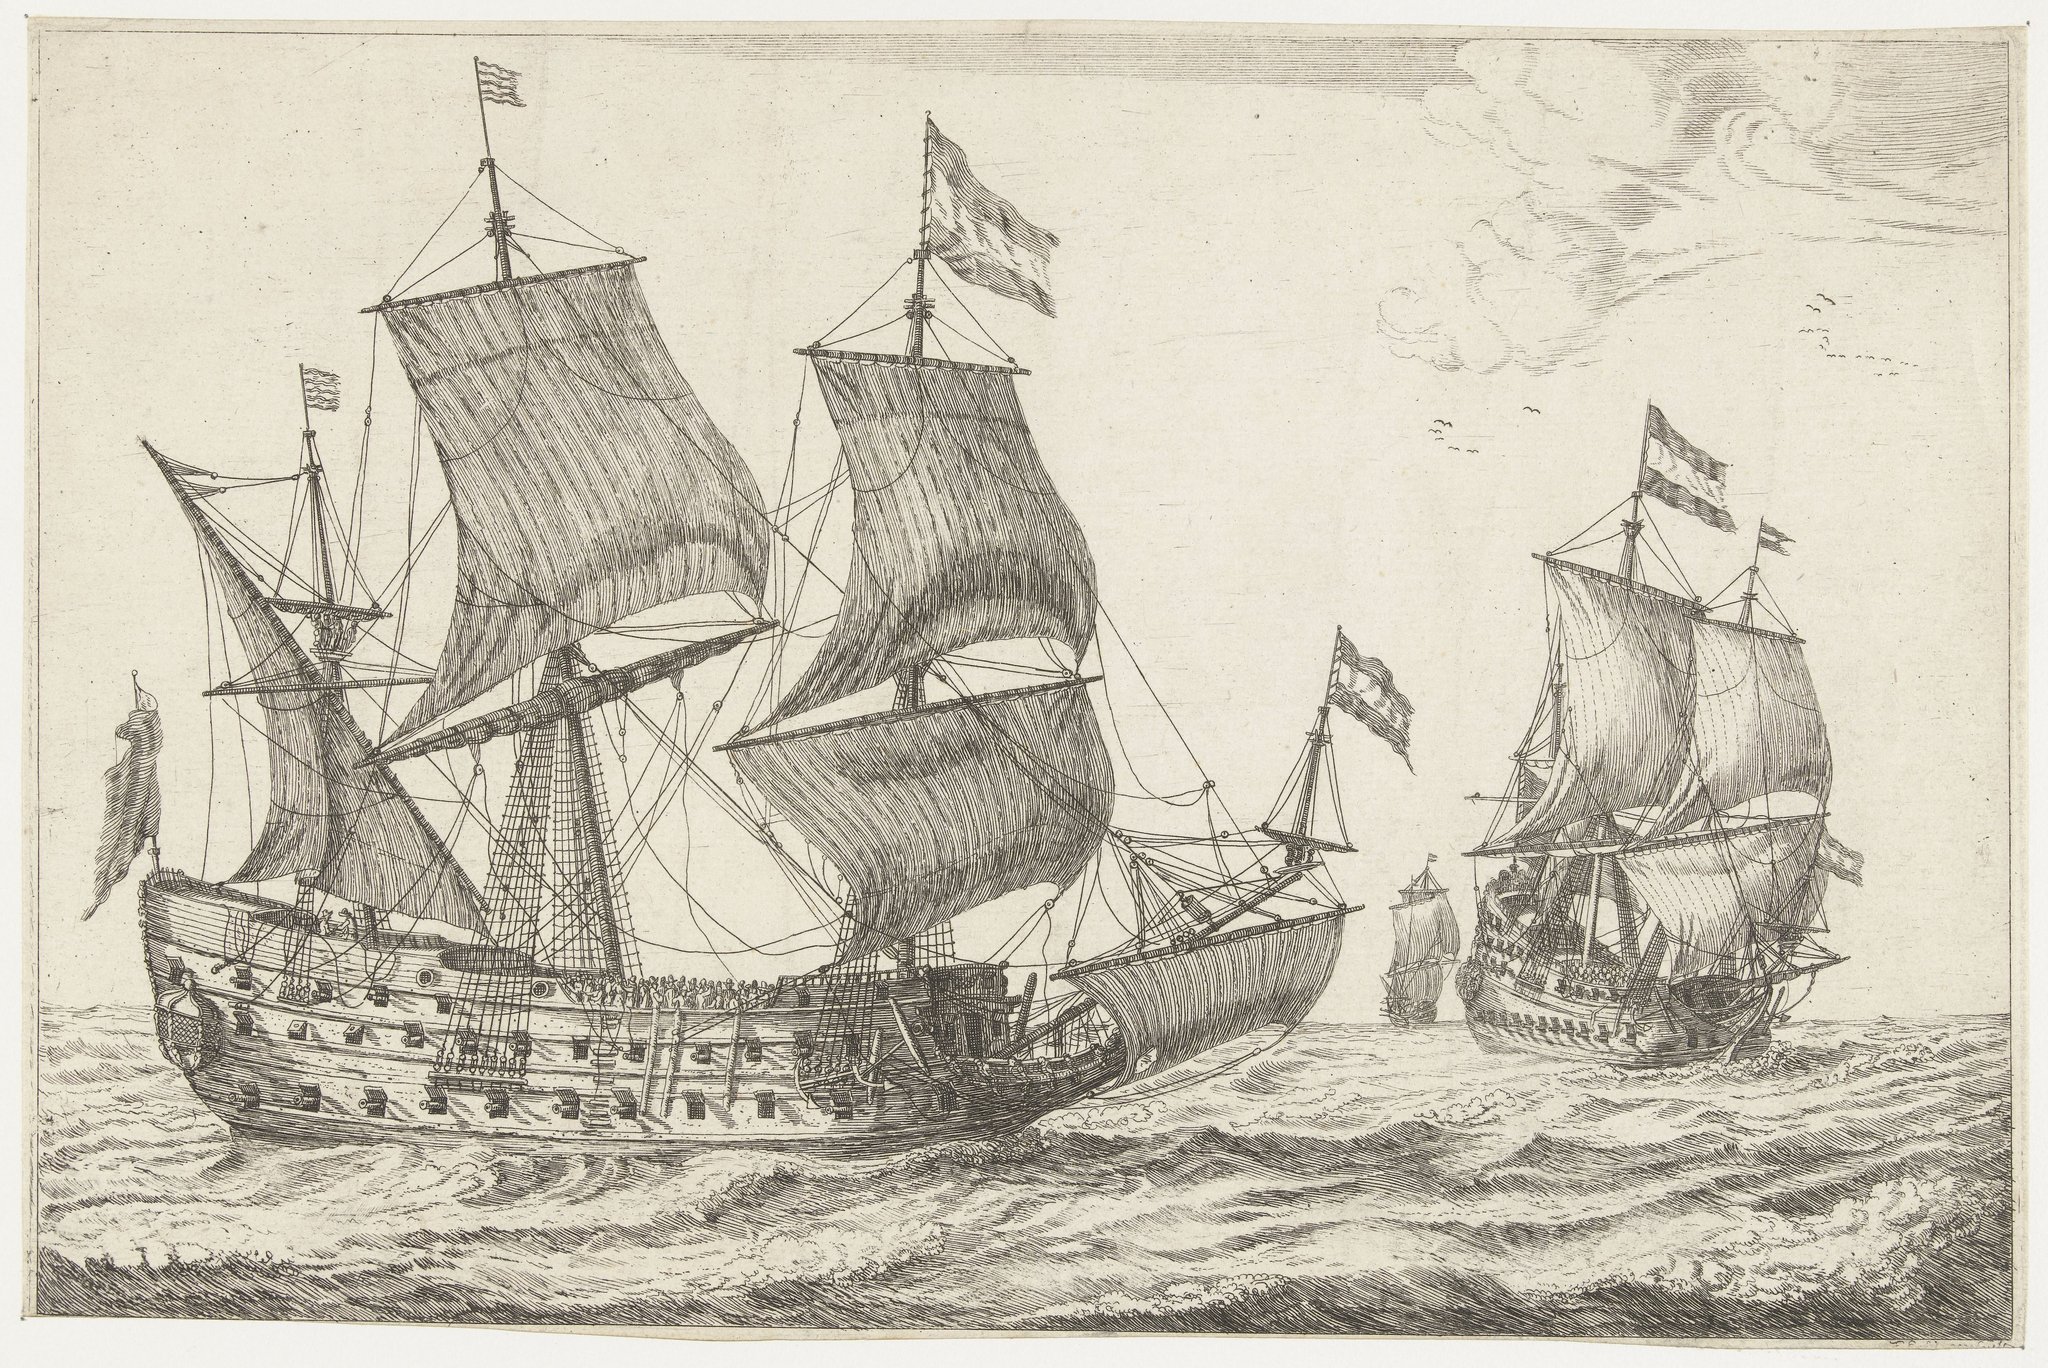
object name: print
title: Twee grote oorlogsschepen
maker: Anonymous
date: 1650-1714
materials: paper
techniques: etching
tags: sailing-ship, sailing-boat (with name)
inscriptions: collector's mark: Lugt 1159, signature: ‘F A (...)’, collector's mark: Lugt 2228a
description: Kopie in spiegelbeeld. Twee grote Nederlandse oorlogsschepen met bemanning op zee, aan de horizon een derde schip.